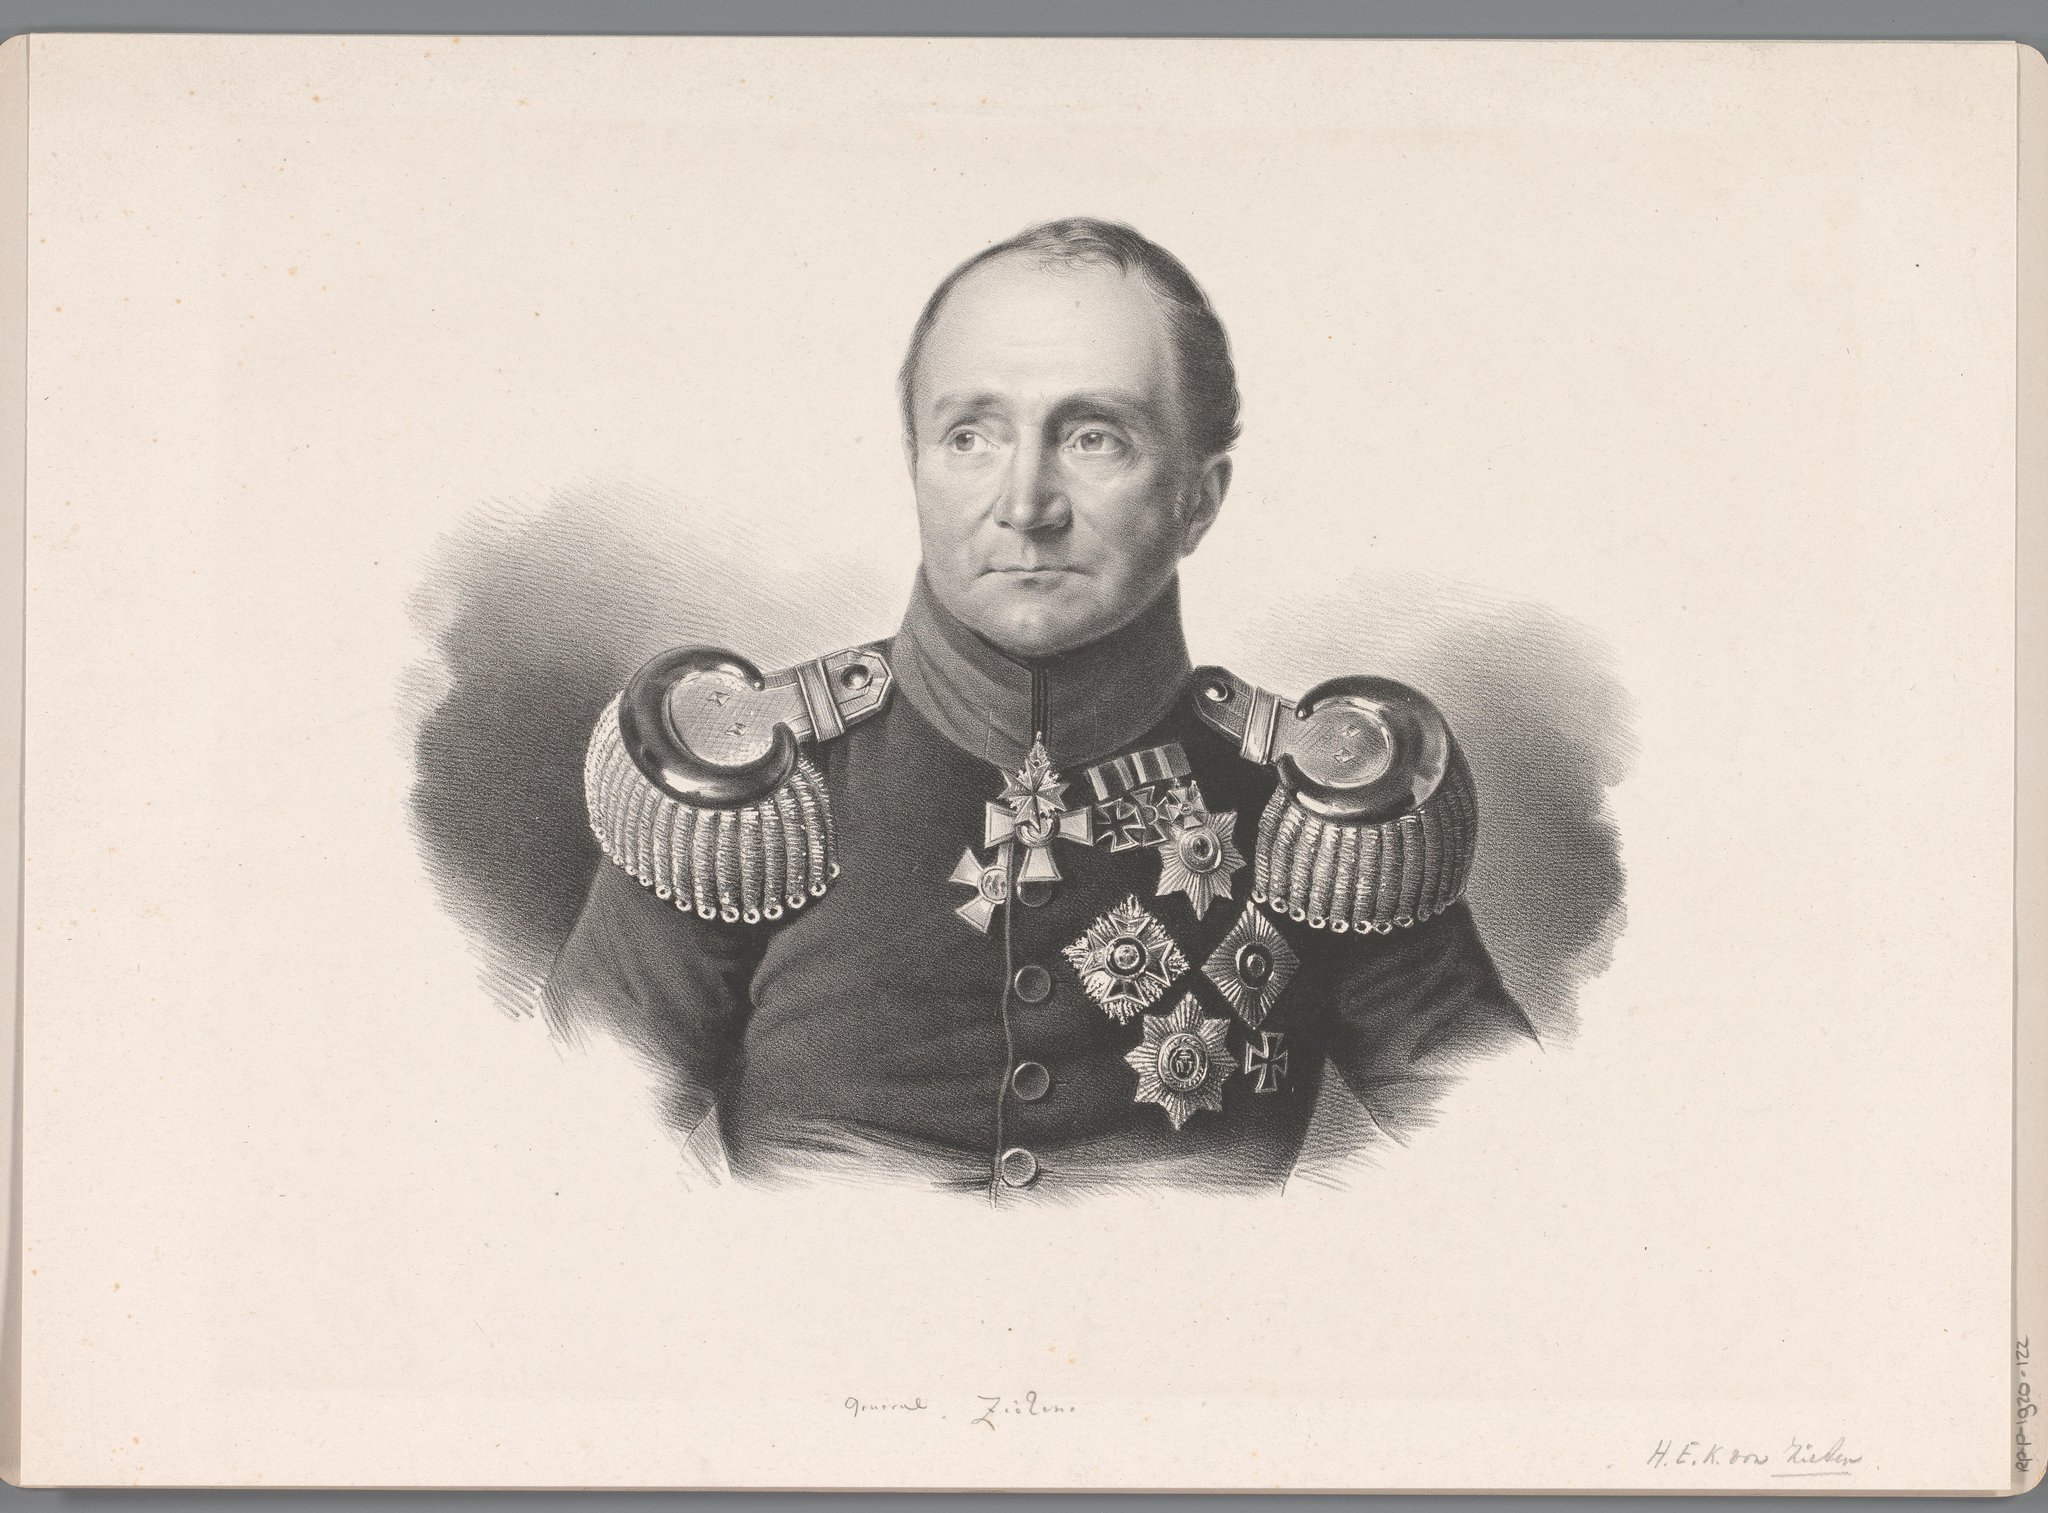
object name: print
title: Portret van Hans Ernst Karel von Zieten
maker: Anonymous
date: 1800-1899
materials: paper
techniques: lithograph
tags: commander-in-chief, general, marshal, historical persons, (military) uniforms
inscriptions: inscription: ‘general. Zieten.’, collector's mark: Lugt 2228